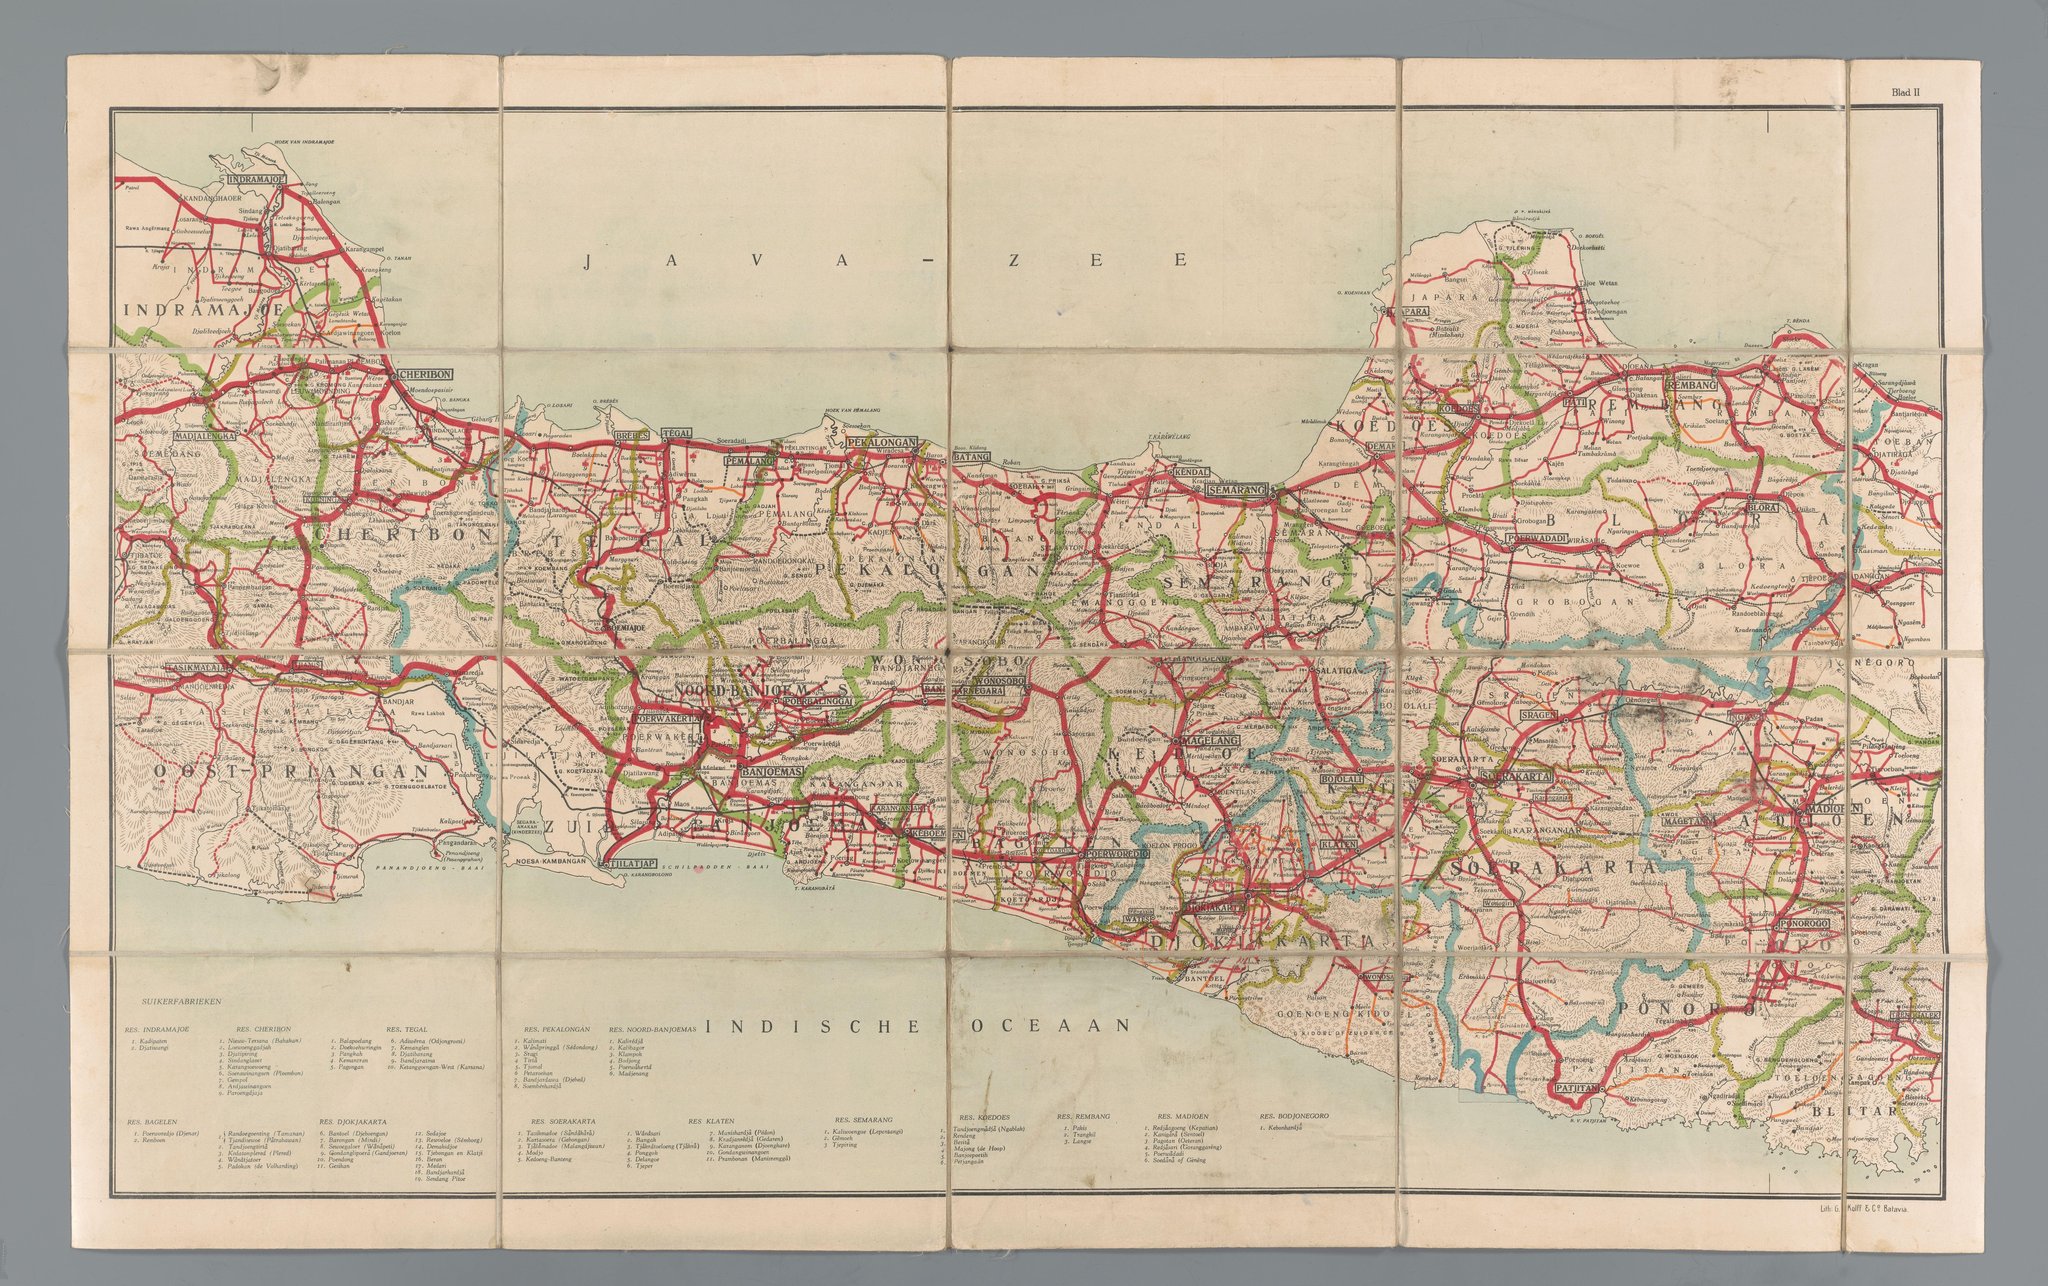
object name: print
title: Wegenkaart van Midden-Java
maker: Anonymous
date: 1906-1938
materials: linen, paper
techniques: lithograph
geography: batavia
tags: maps of separate countries or regions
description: Schaal 1:500.000. Onder de kaart een legenda van suikerfabrieken per regentschap.